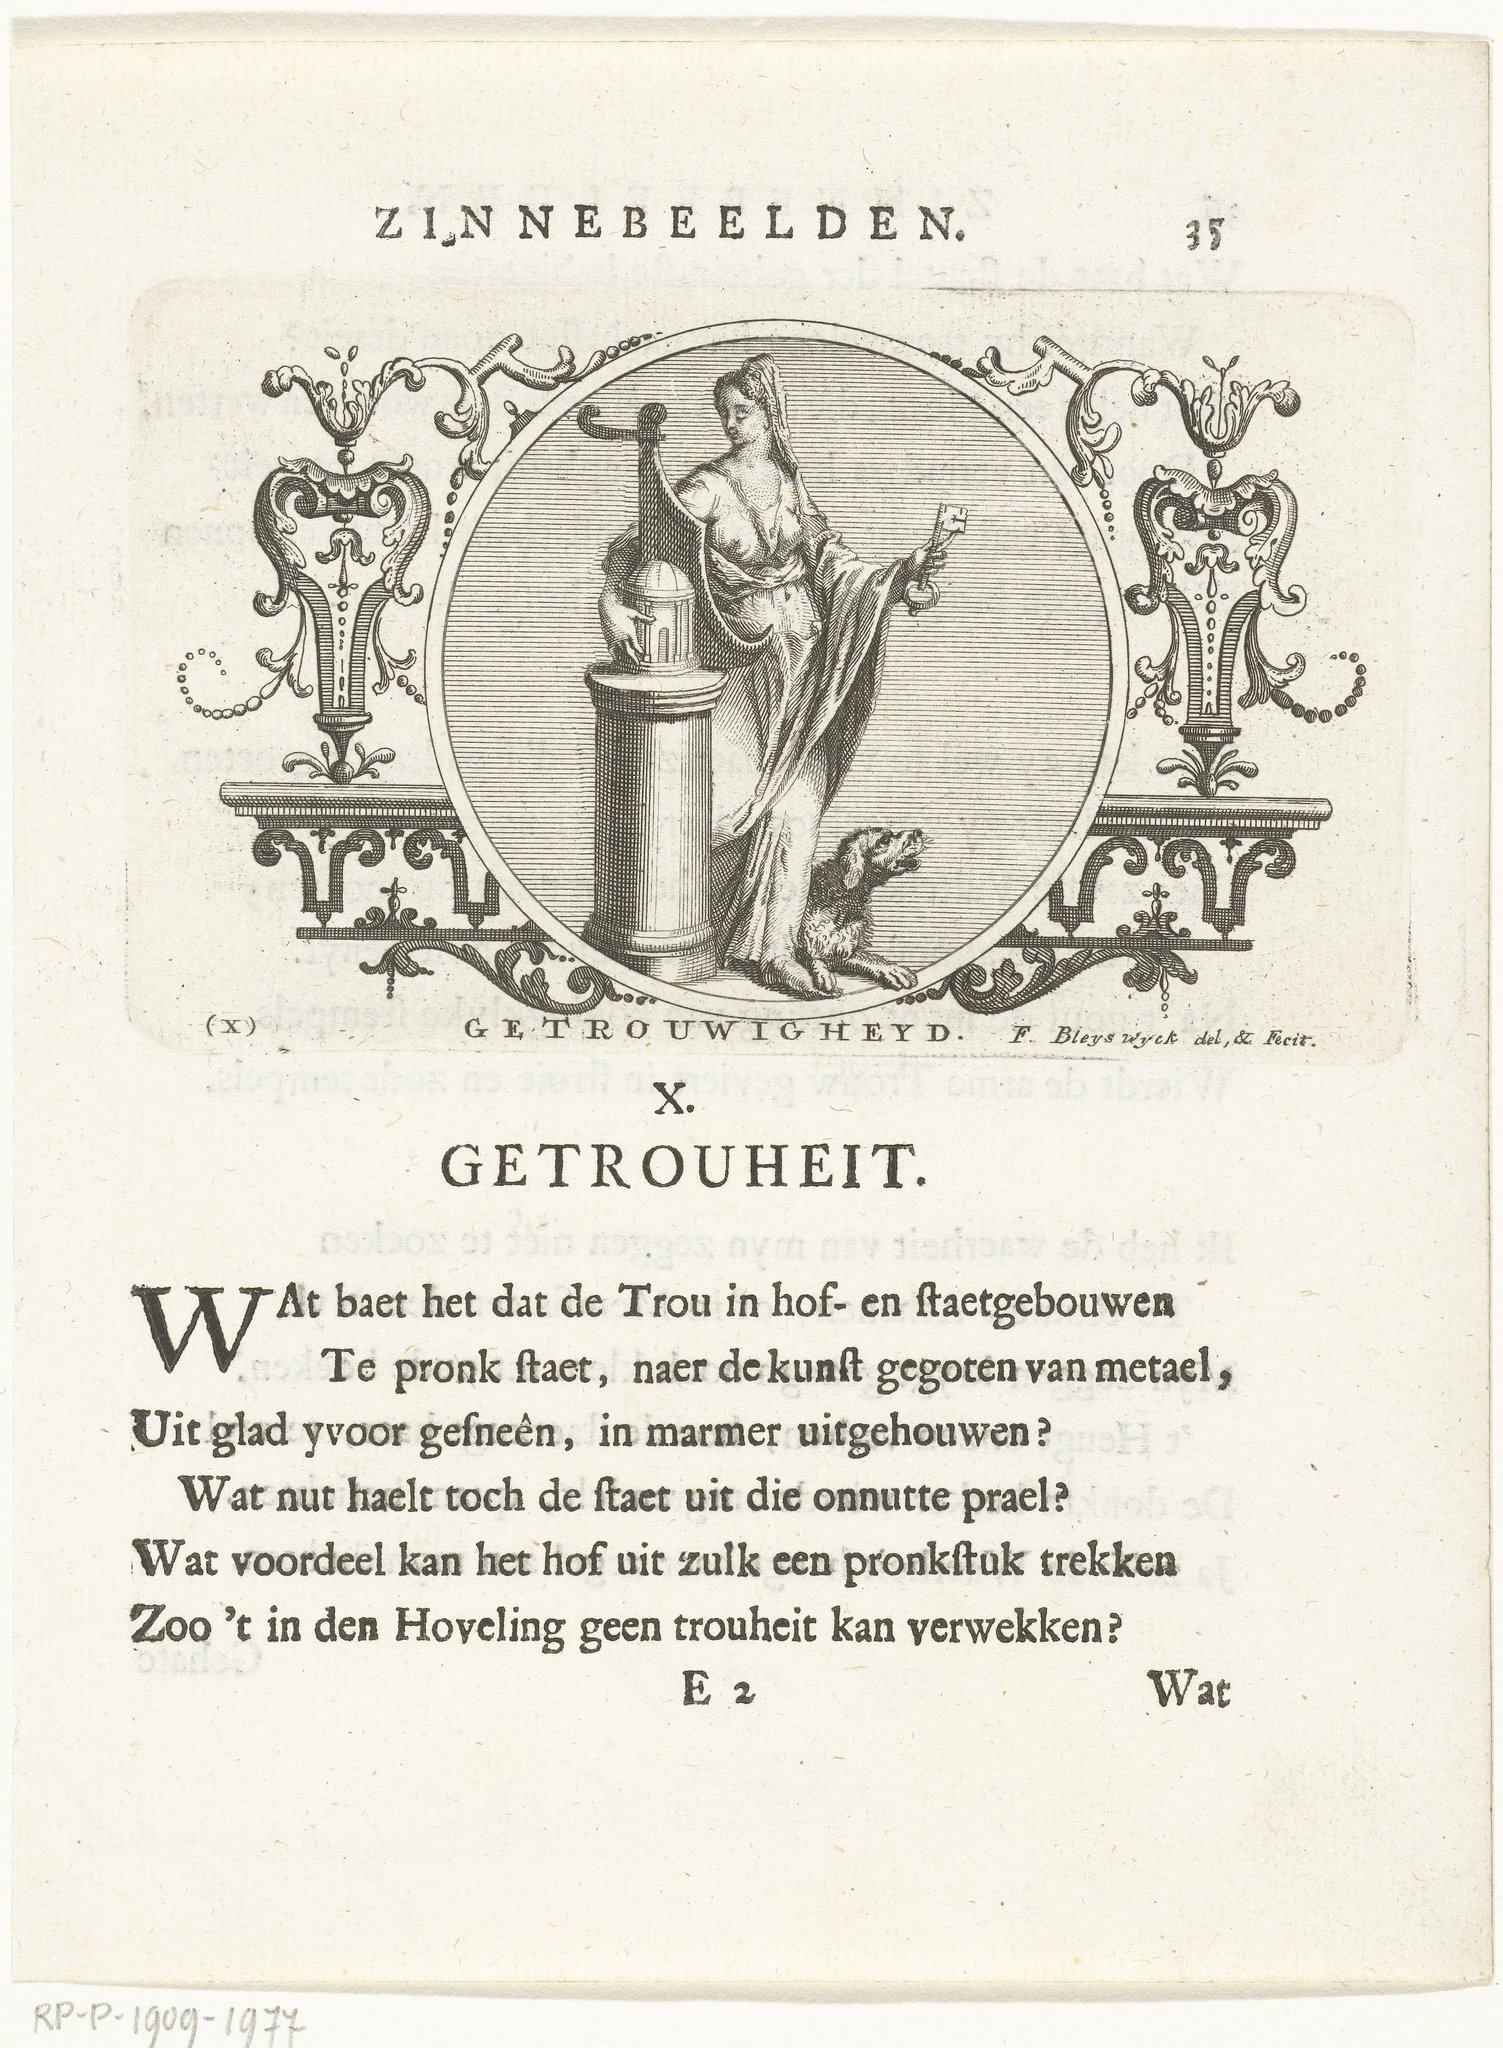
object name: print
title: Getrouwigheyd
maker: françois van bleyswijck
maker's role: draughtsman, print maker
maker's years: 1671-1746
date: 1681-1737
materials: paper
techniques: etching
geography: leiden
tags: trustworthiness, reliability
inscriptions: collector's mark: Lugt 2228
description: Embleem met allegorie op betrouwbaarheid verbeeld als vrouw met sleutel, roer, kerkmodel en hond in ronde omlijsting versierd met ornamenten.